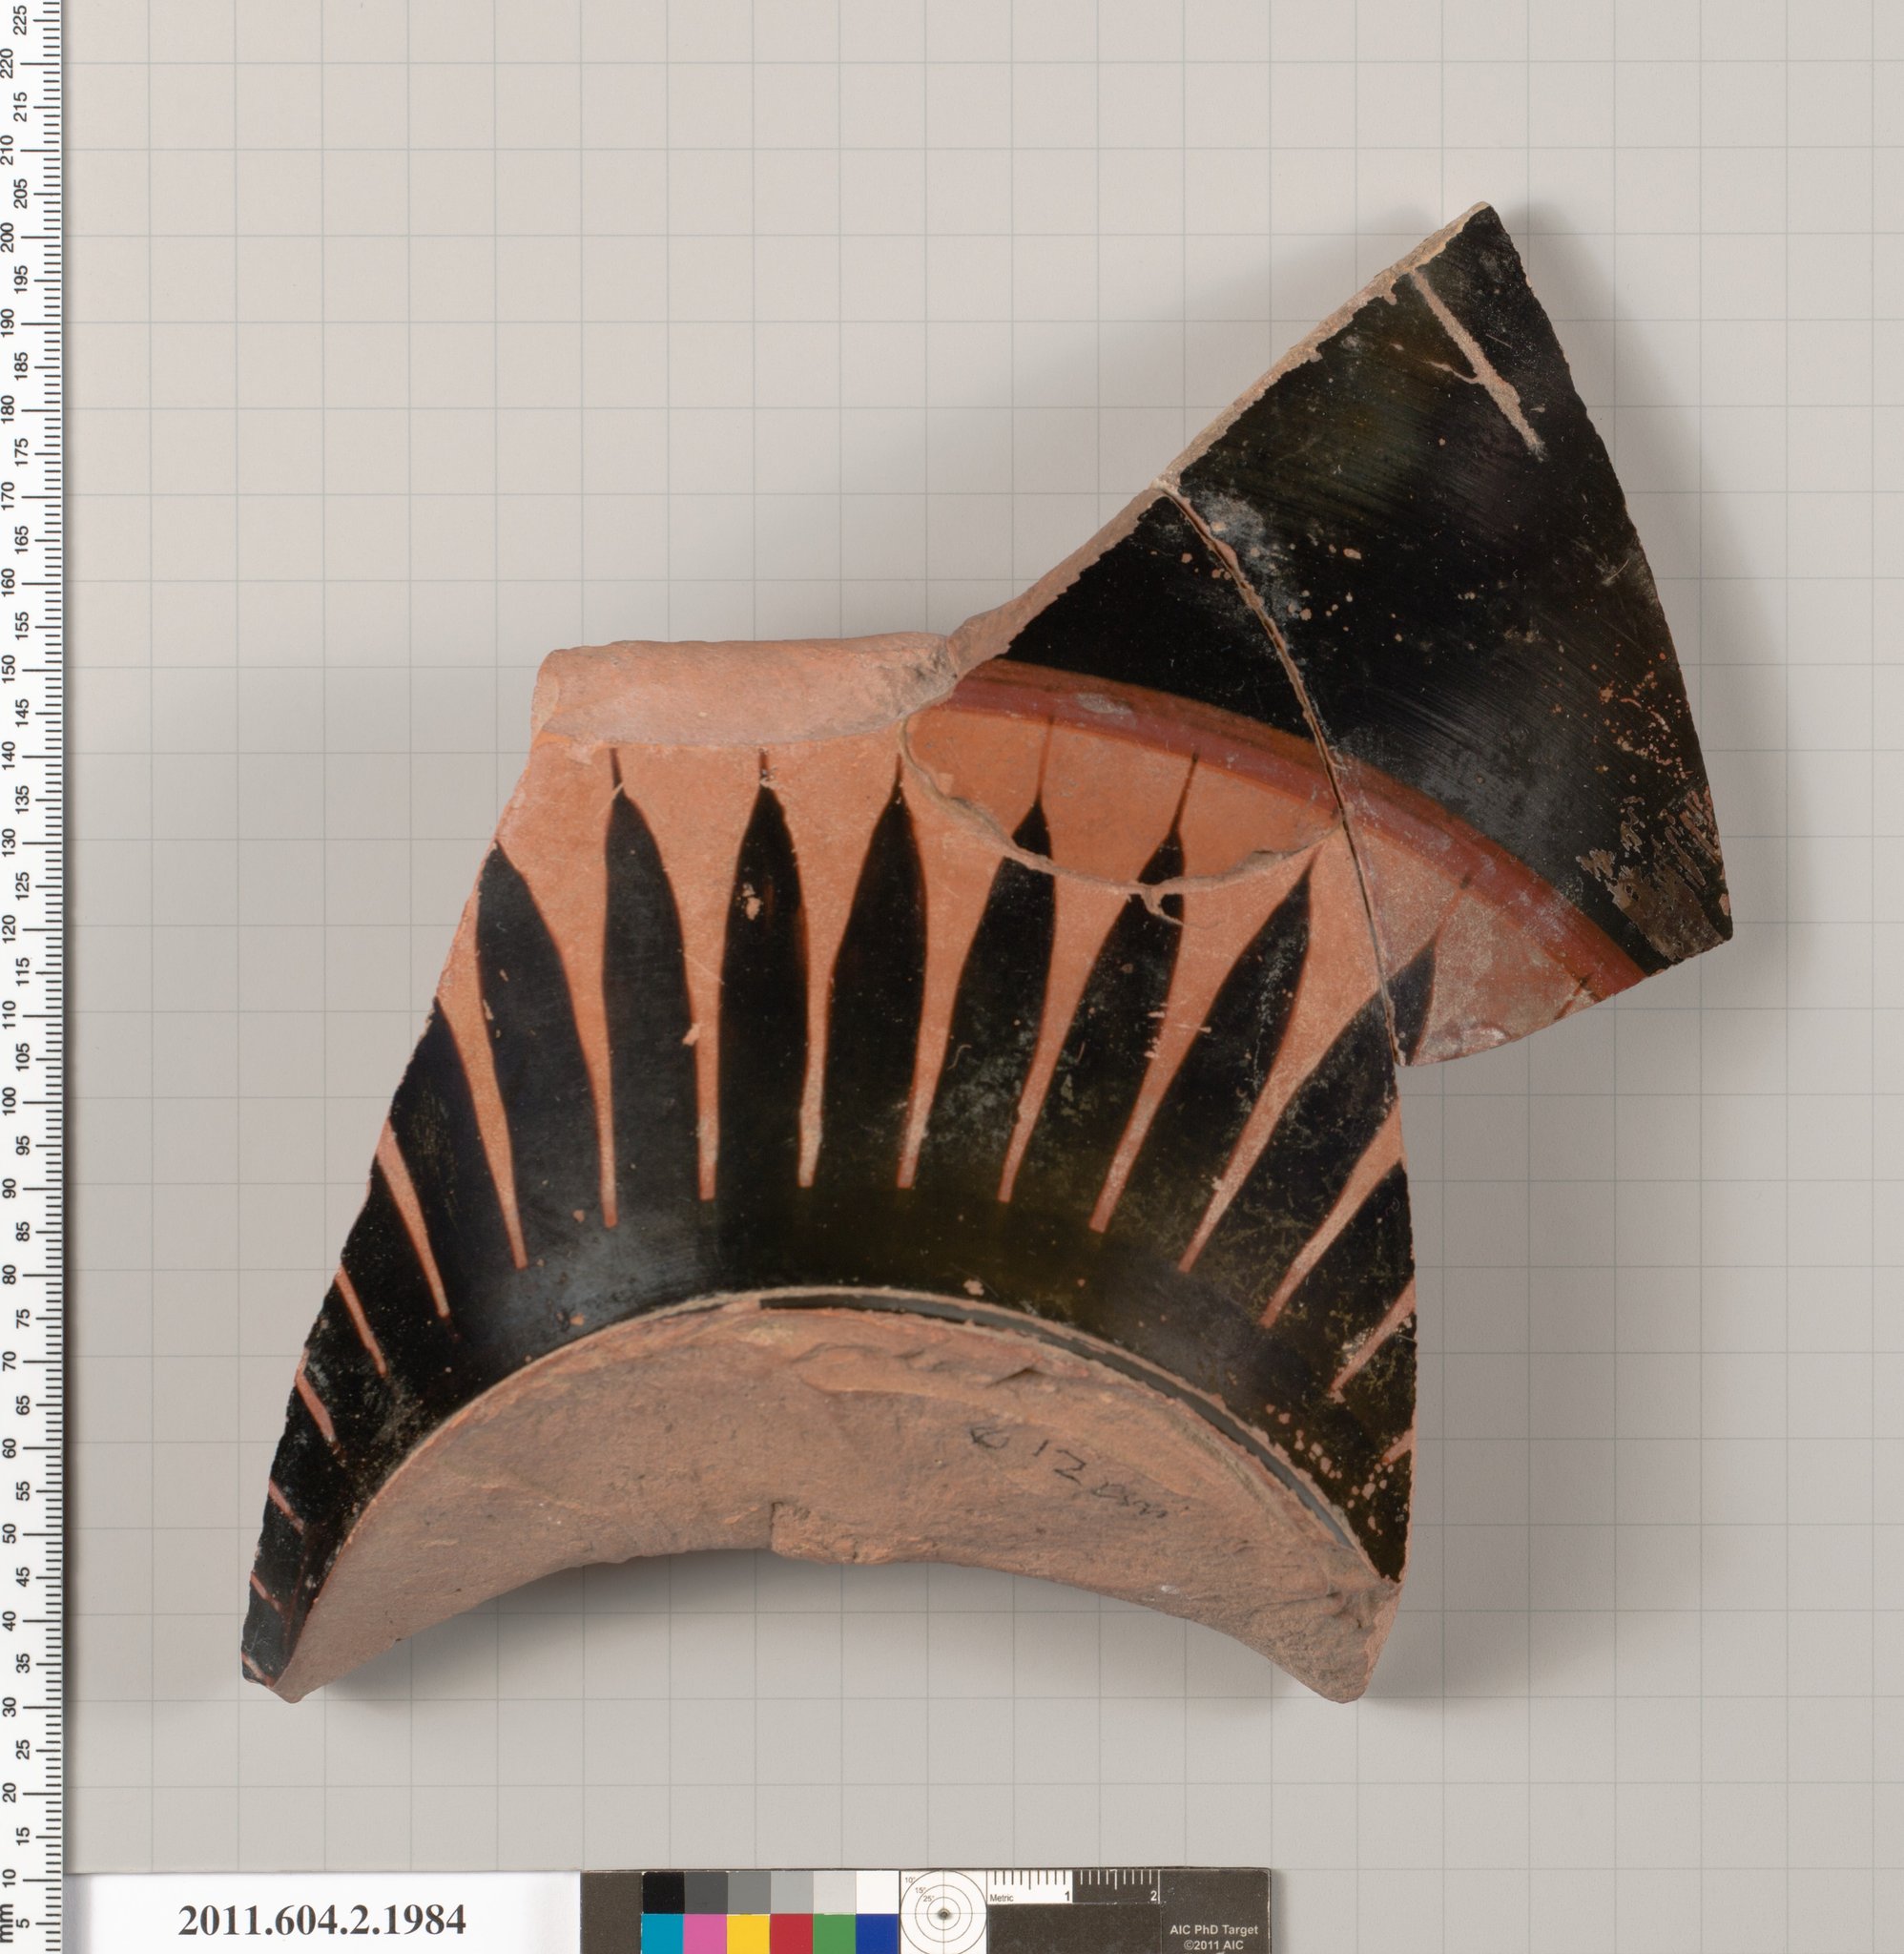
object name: amphora fragment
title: Terracotta fragment of an amphora (jar)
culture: greek, attic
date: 475-451 BCE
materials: terracotta